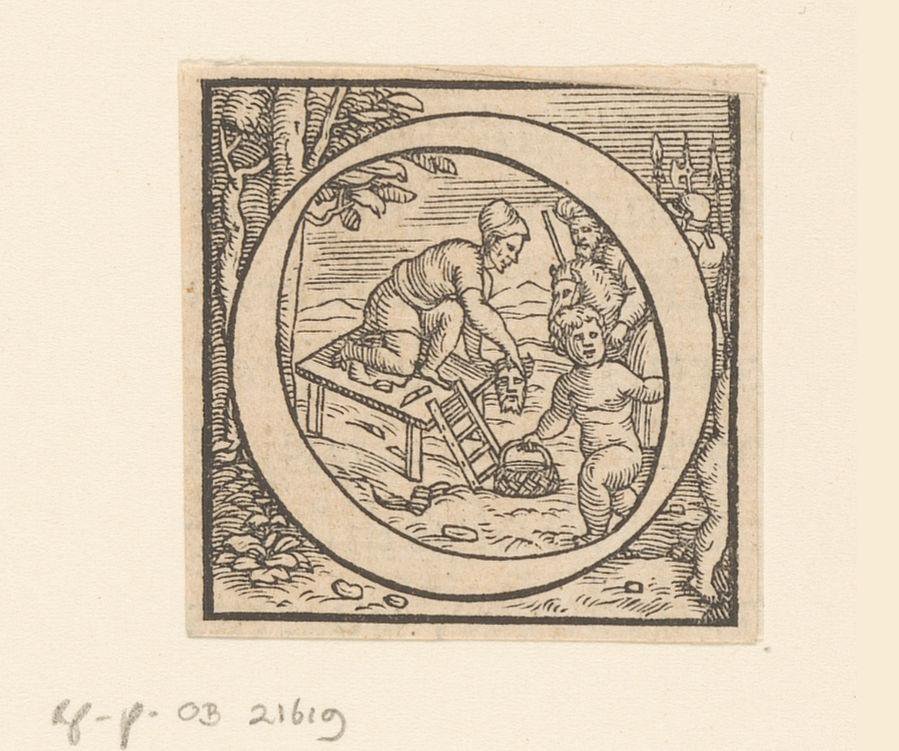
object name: book illustration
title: Versierde initialen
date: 1543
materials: paper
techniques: woodcut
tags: letters, alphabet, script, physiology and anatomy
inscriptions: collector's mark: Lugt 2227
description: Prent uit: Vesalius, Andreas. De Humani Corporis Fabrica. Bazel: Jan Herpst, 1543.